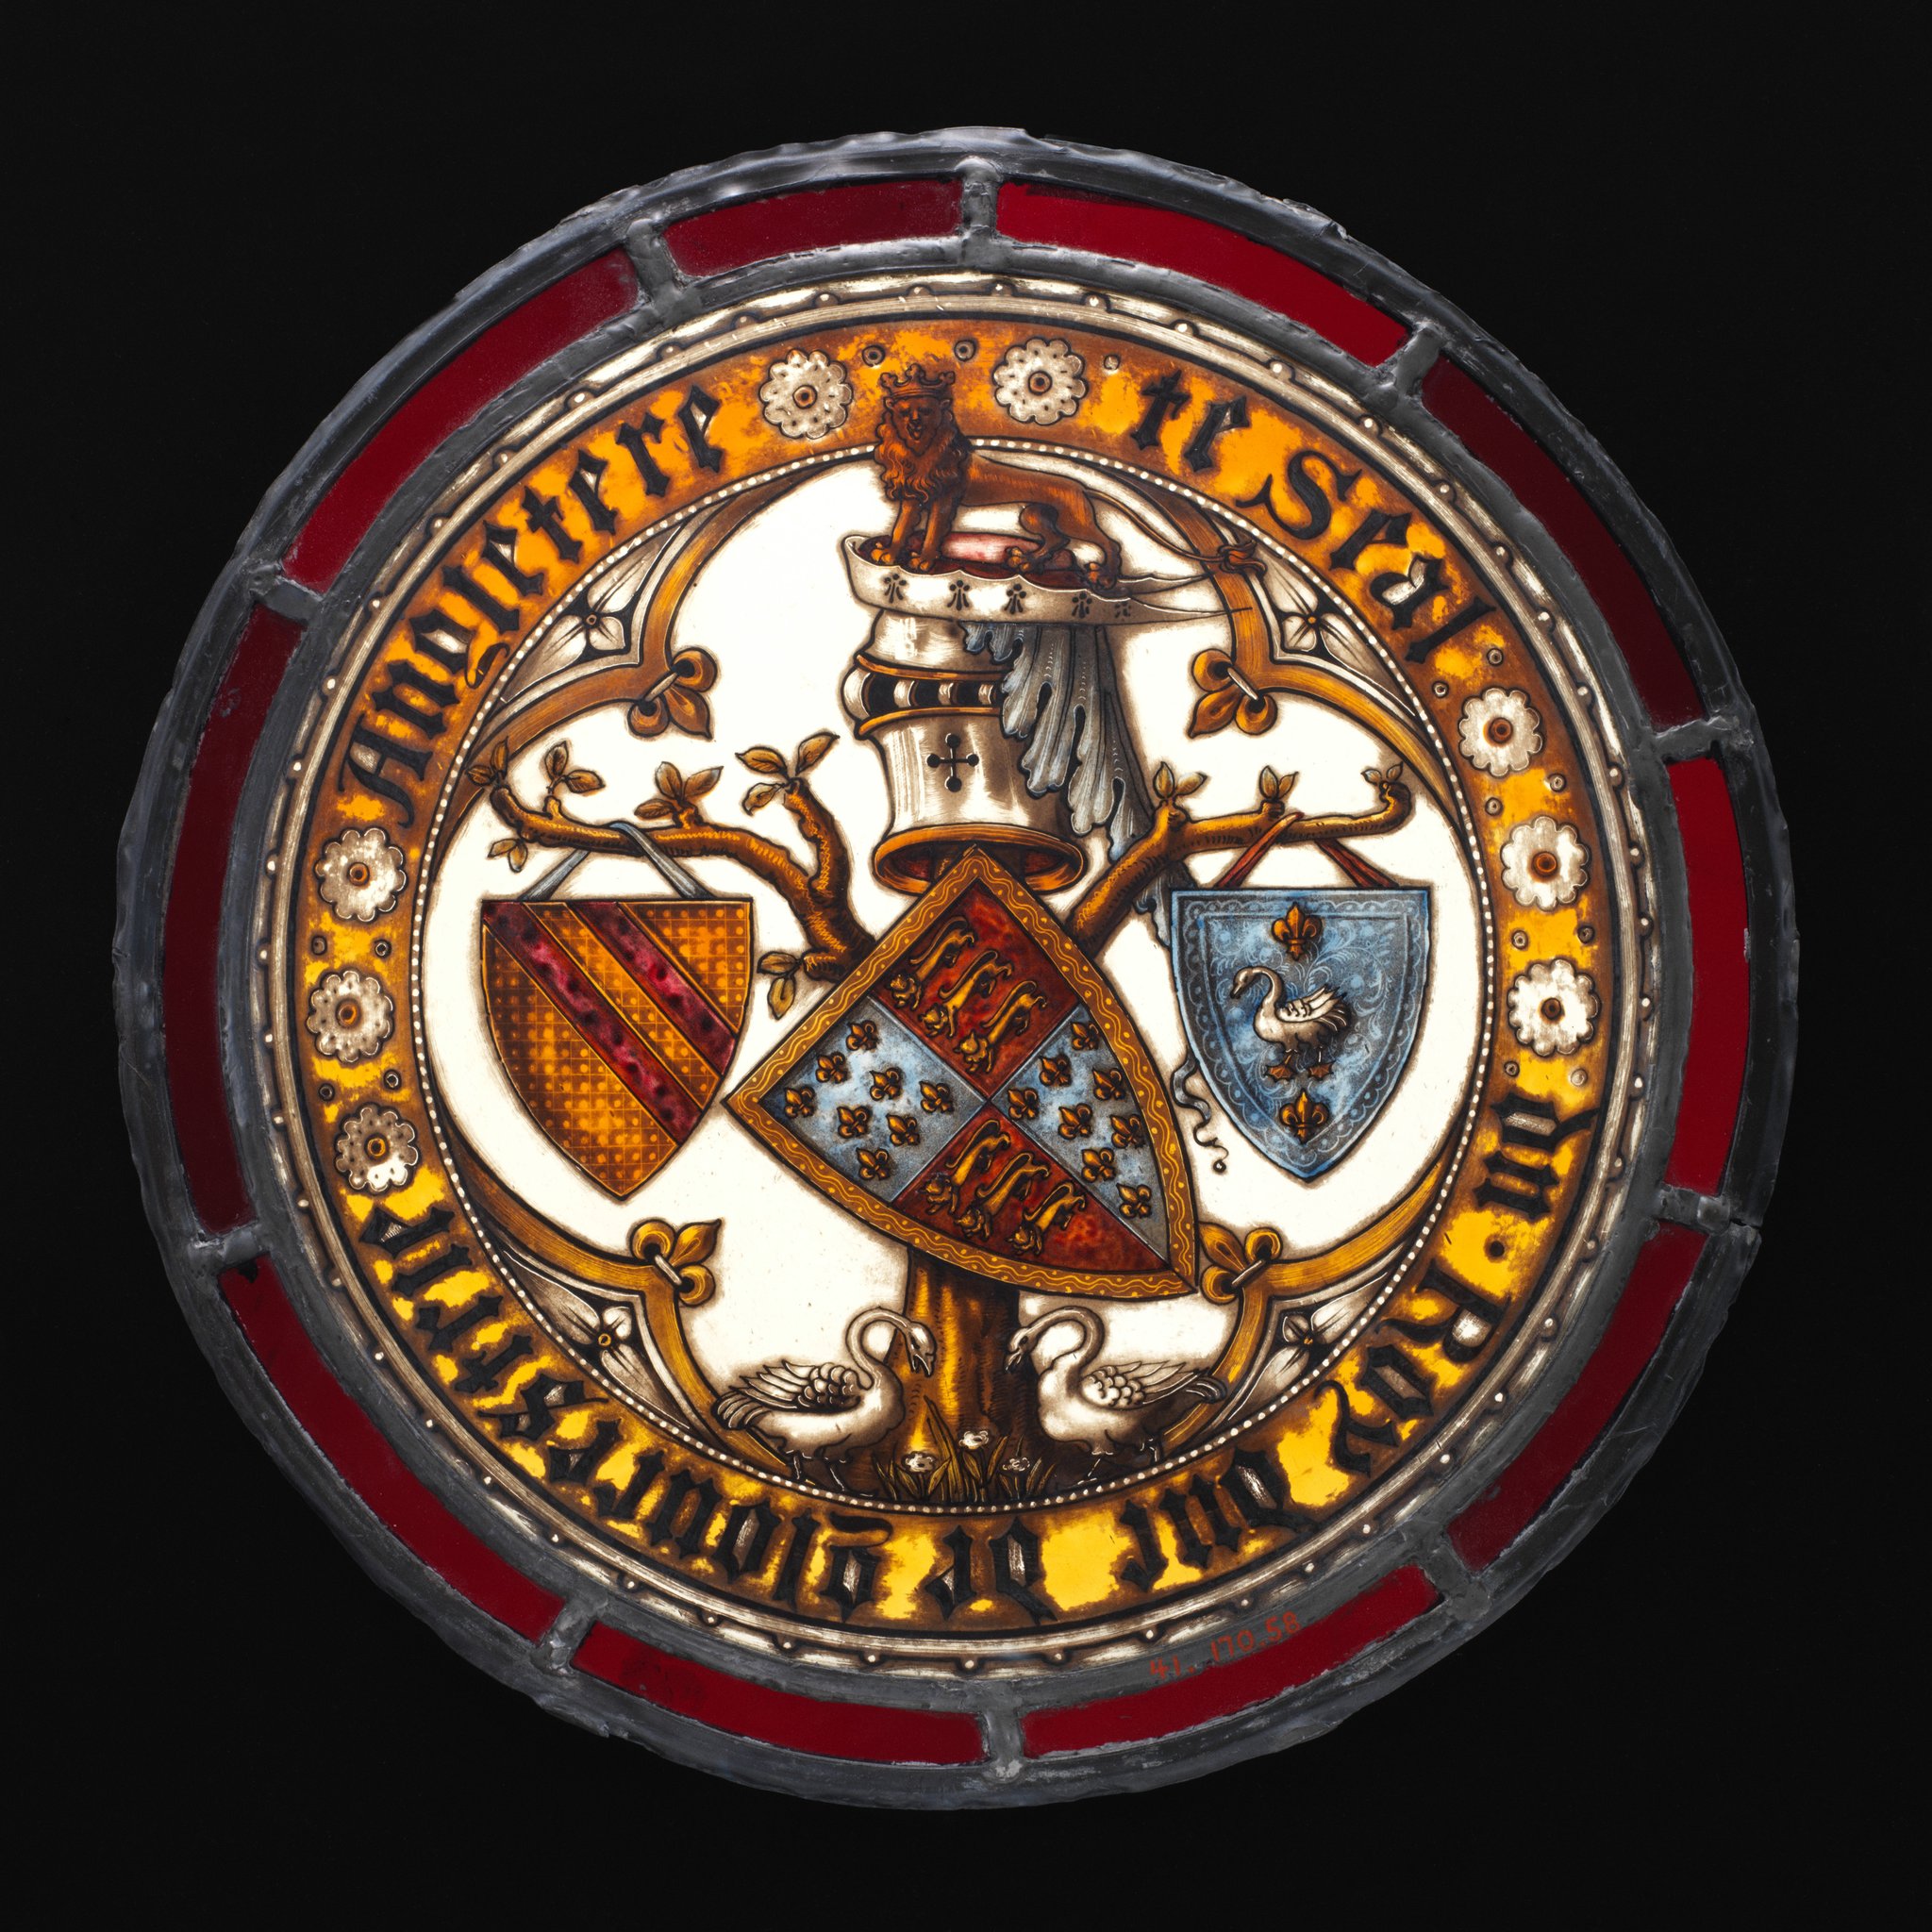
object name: medallion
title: Armorial panel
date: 1801-1850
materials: glass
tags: cranes,shields,coat of arms